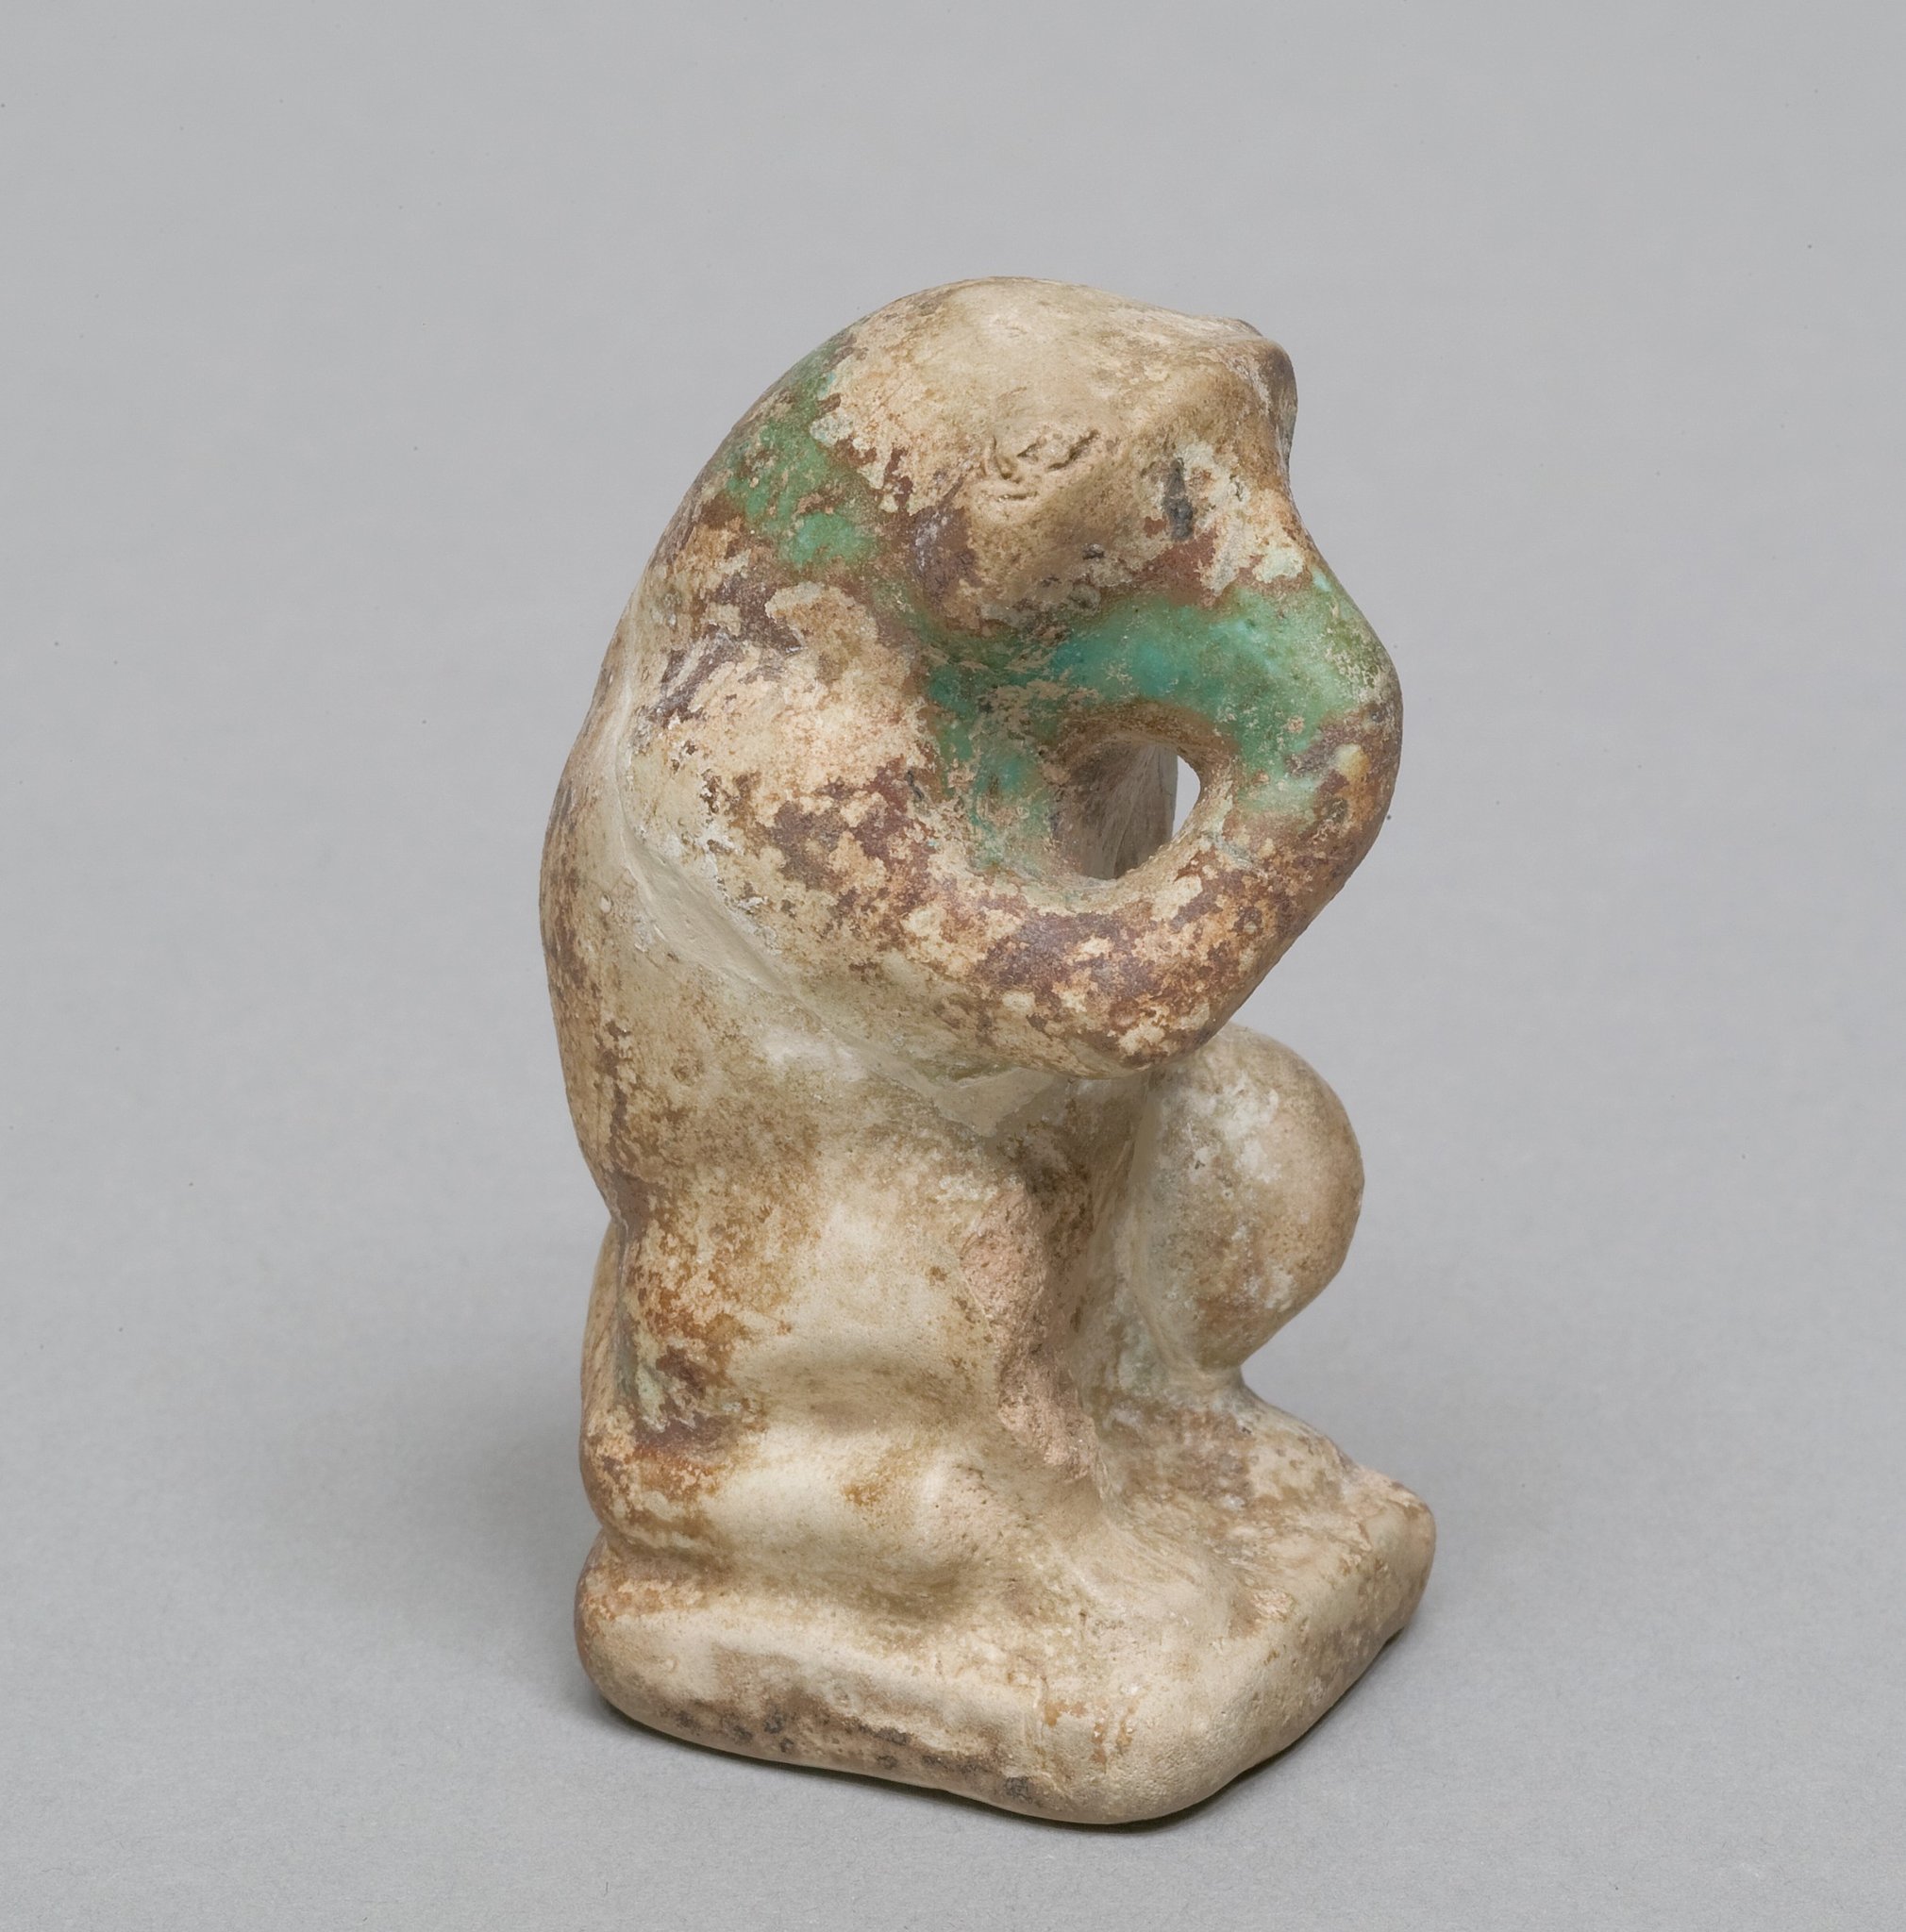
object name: figurine, baboon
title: Baboon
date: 1850-1700 BCE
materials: faience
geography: egypt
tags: baboons